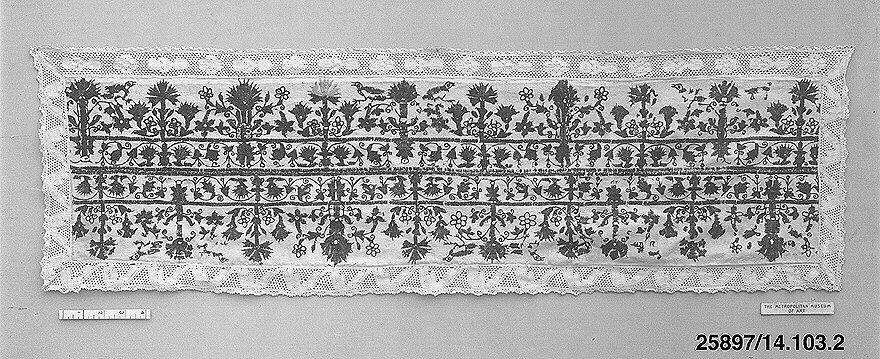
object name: panel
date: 1701-1800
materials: linen, silk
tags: birds,flowers